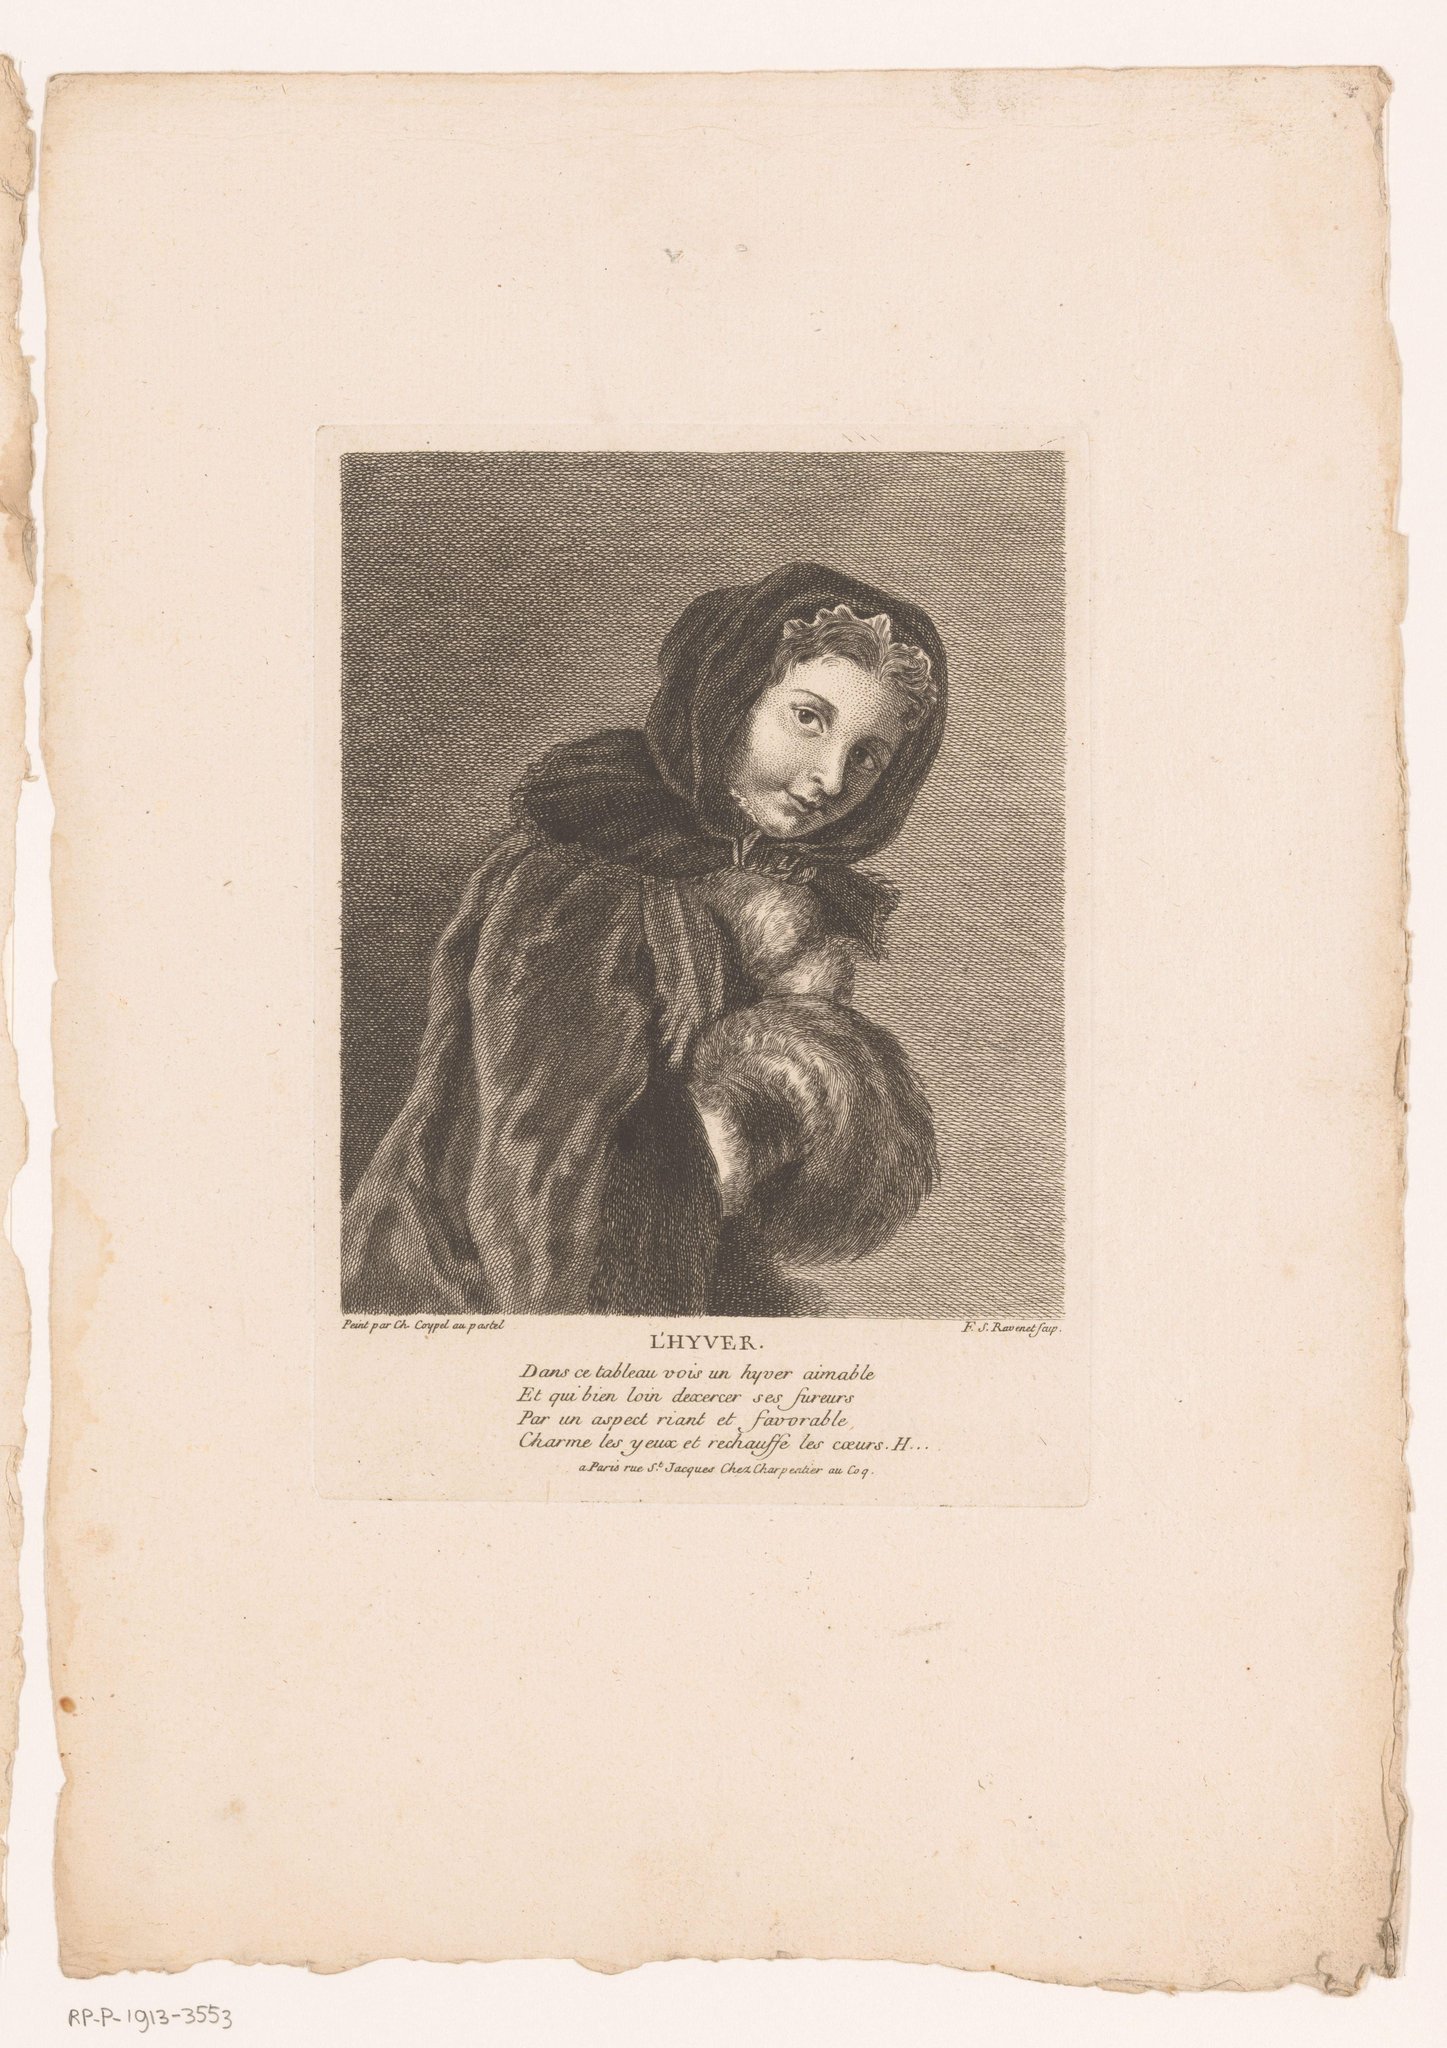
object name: print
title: Winter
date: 1716-1774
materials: paper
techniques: engraving, etching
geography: paris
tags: seasons of the year represented by scenes showing human activities, usually in a landscape, winter, 'hyems'; 'inverno' (ripa)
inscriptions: collector's mark: Lugt 2228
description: Personificatie van de winter als een vrouw in warme kledij.